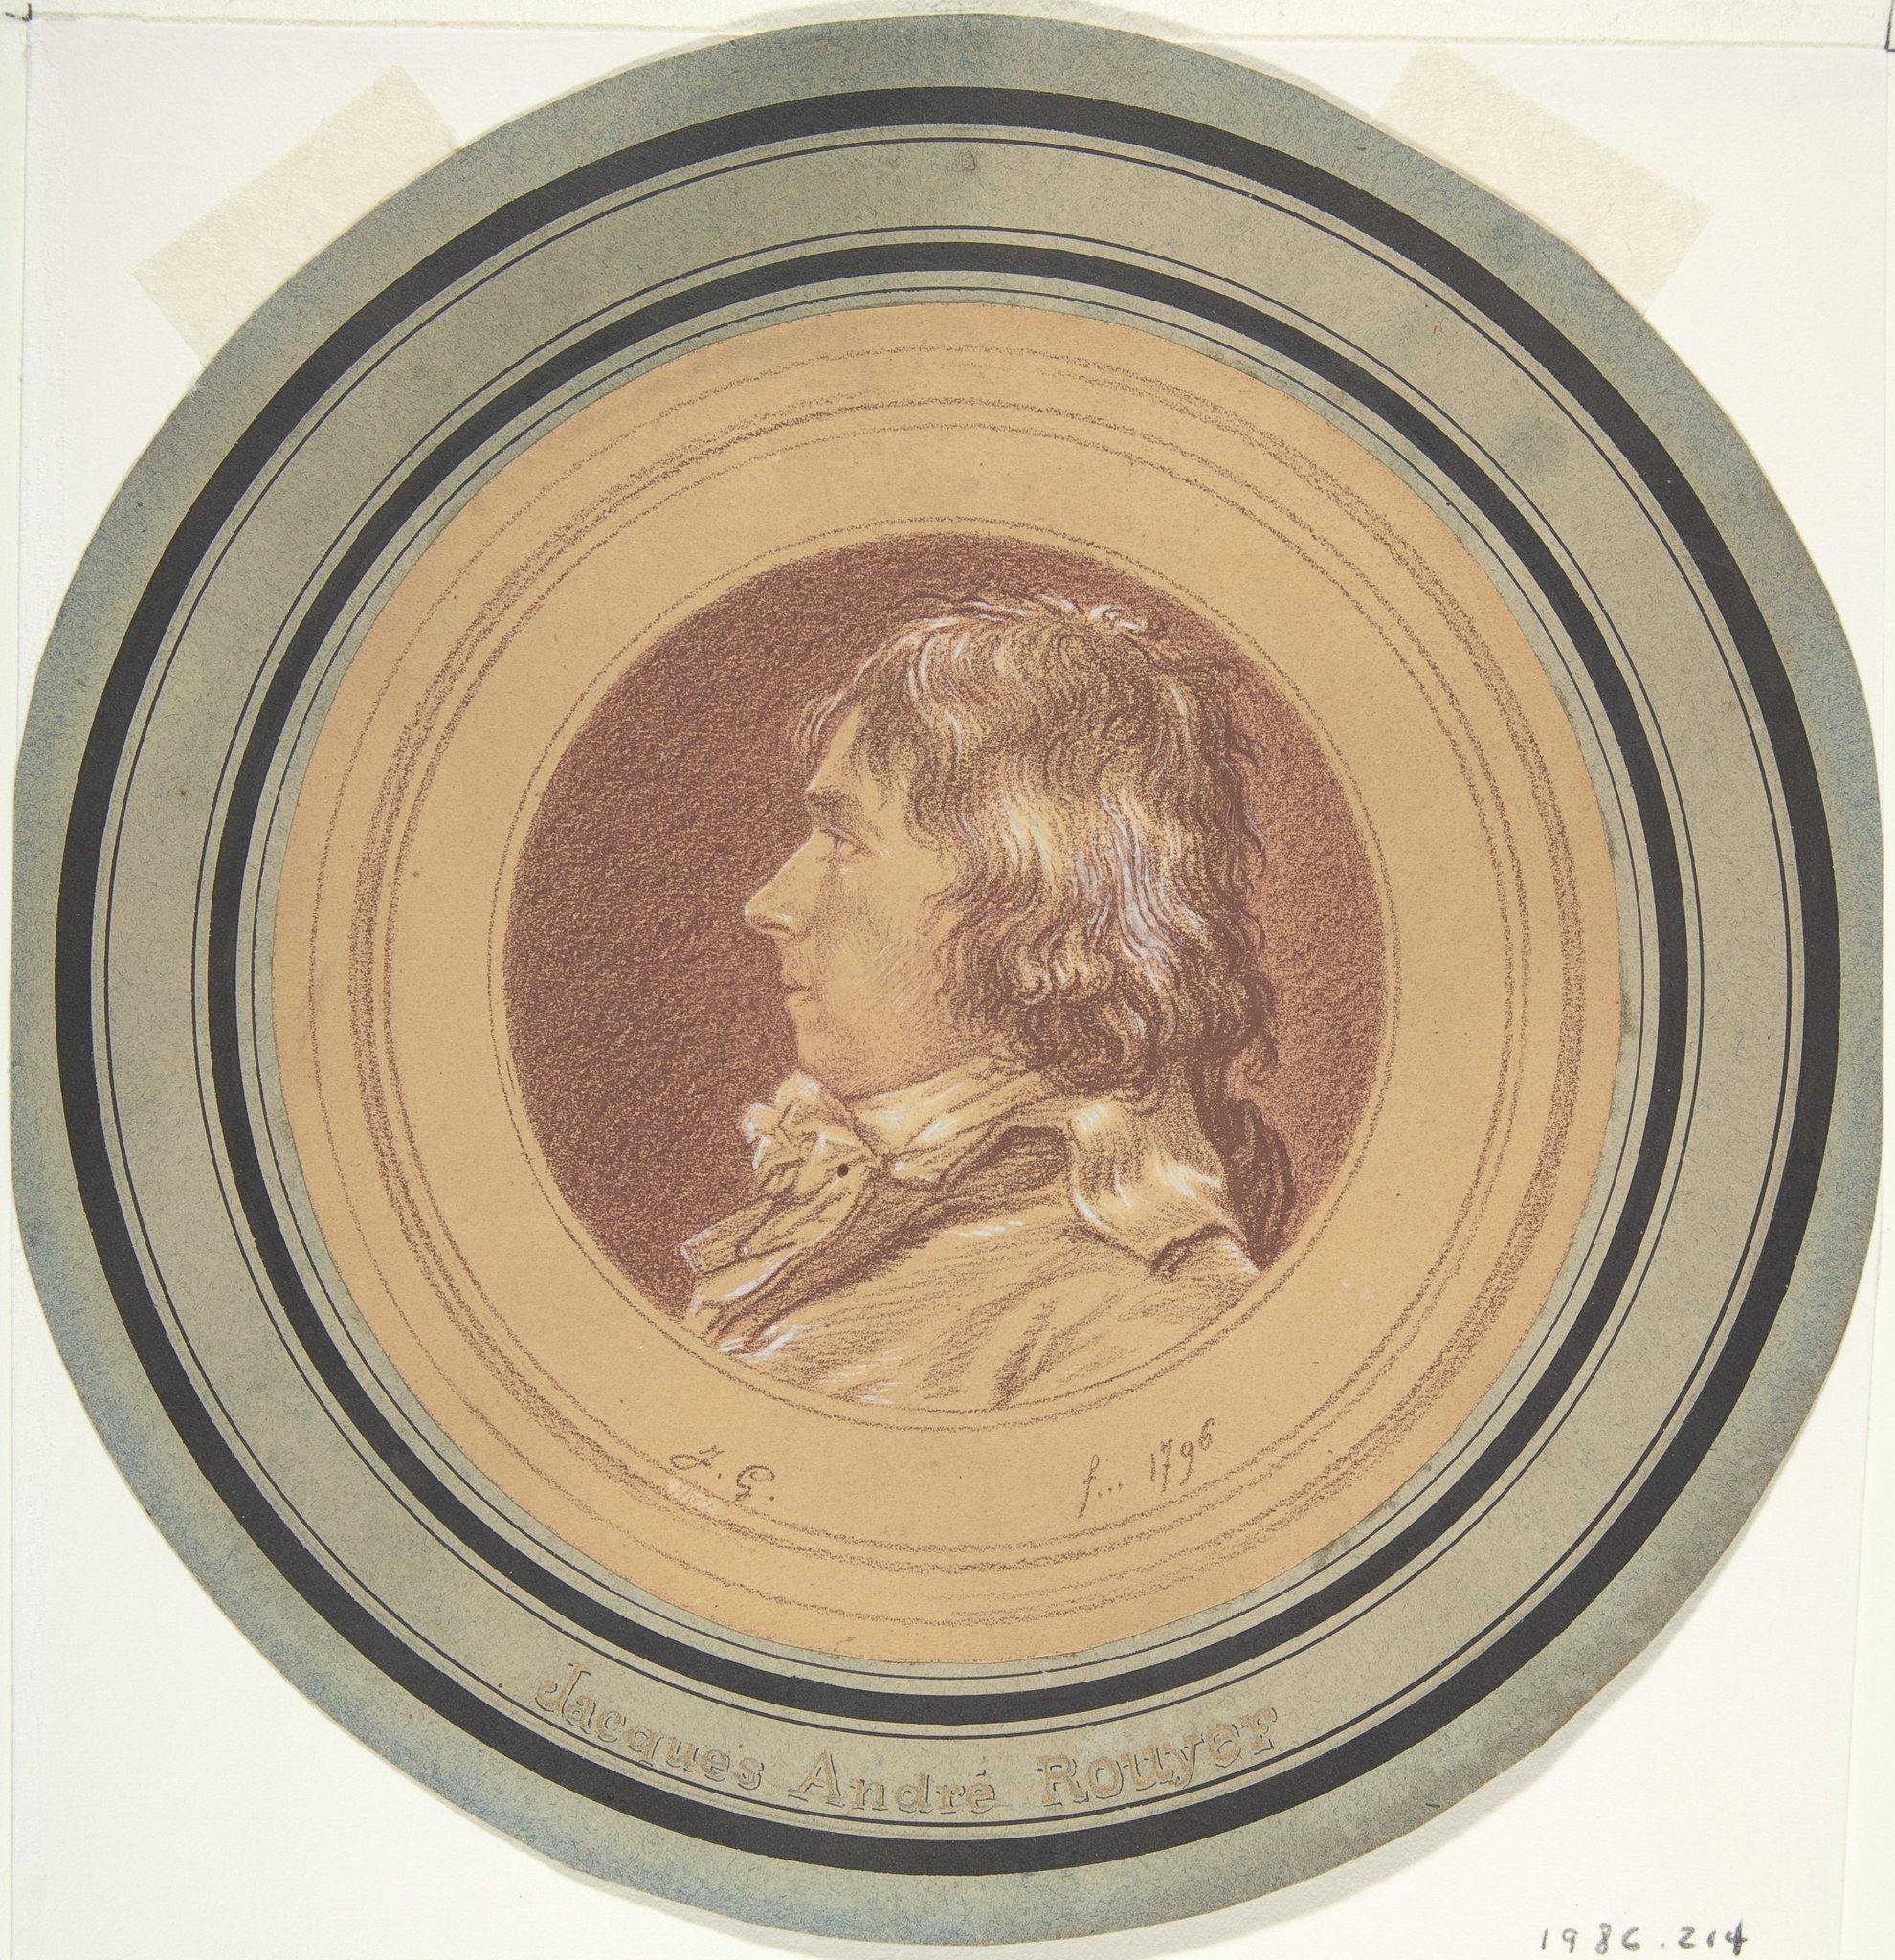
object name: drawing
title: Bust of a Man in Profile to Left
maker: jacques gamelin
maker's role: artist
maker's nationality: french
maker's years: 1738-1803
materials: chalk, paper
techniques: heightening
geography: france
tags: men